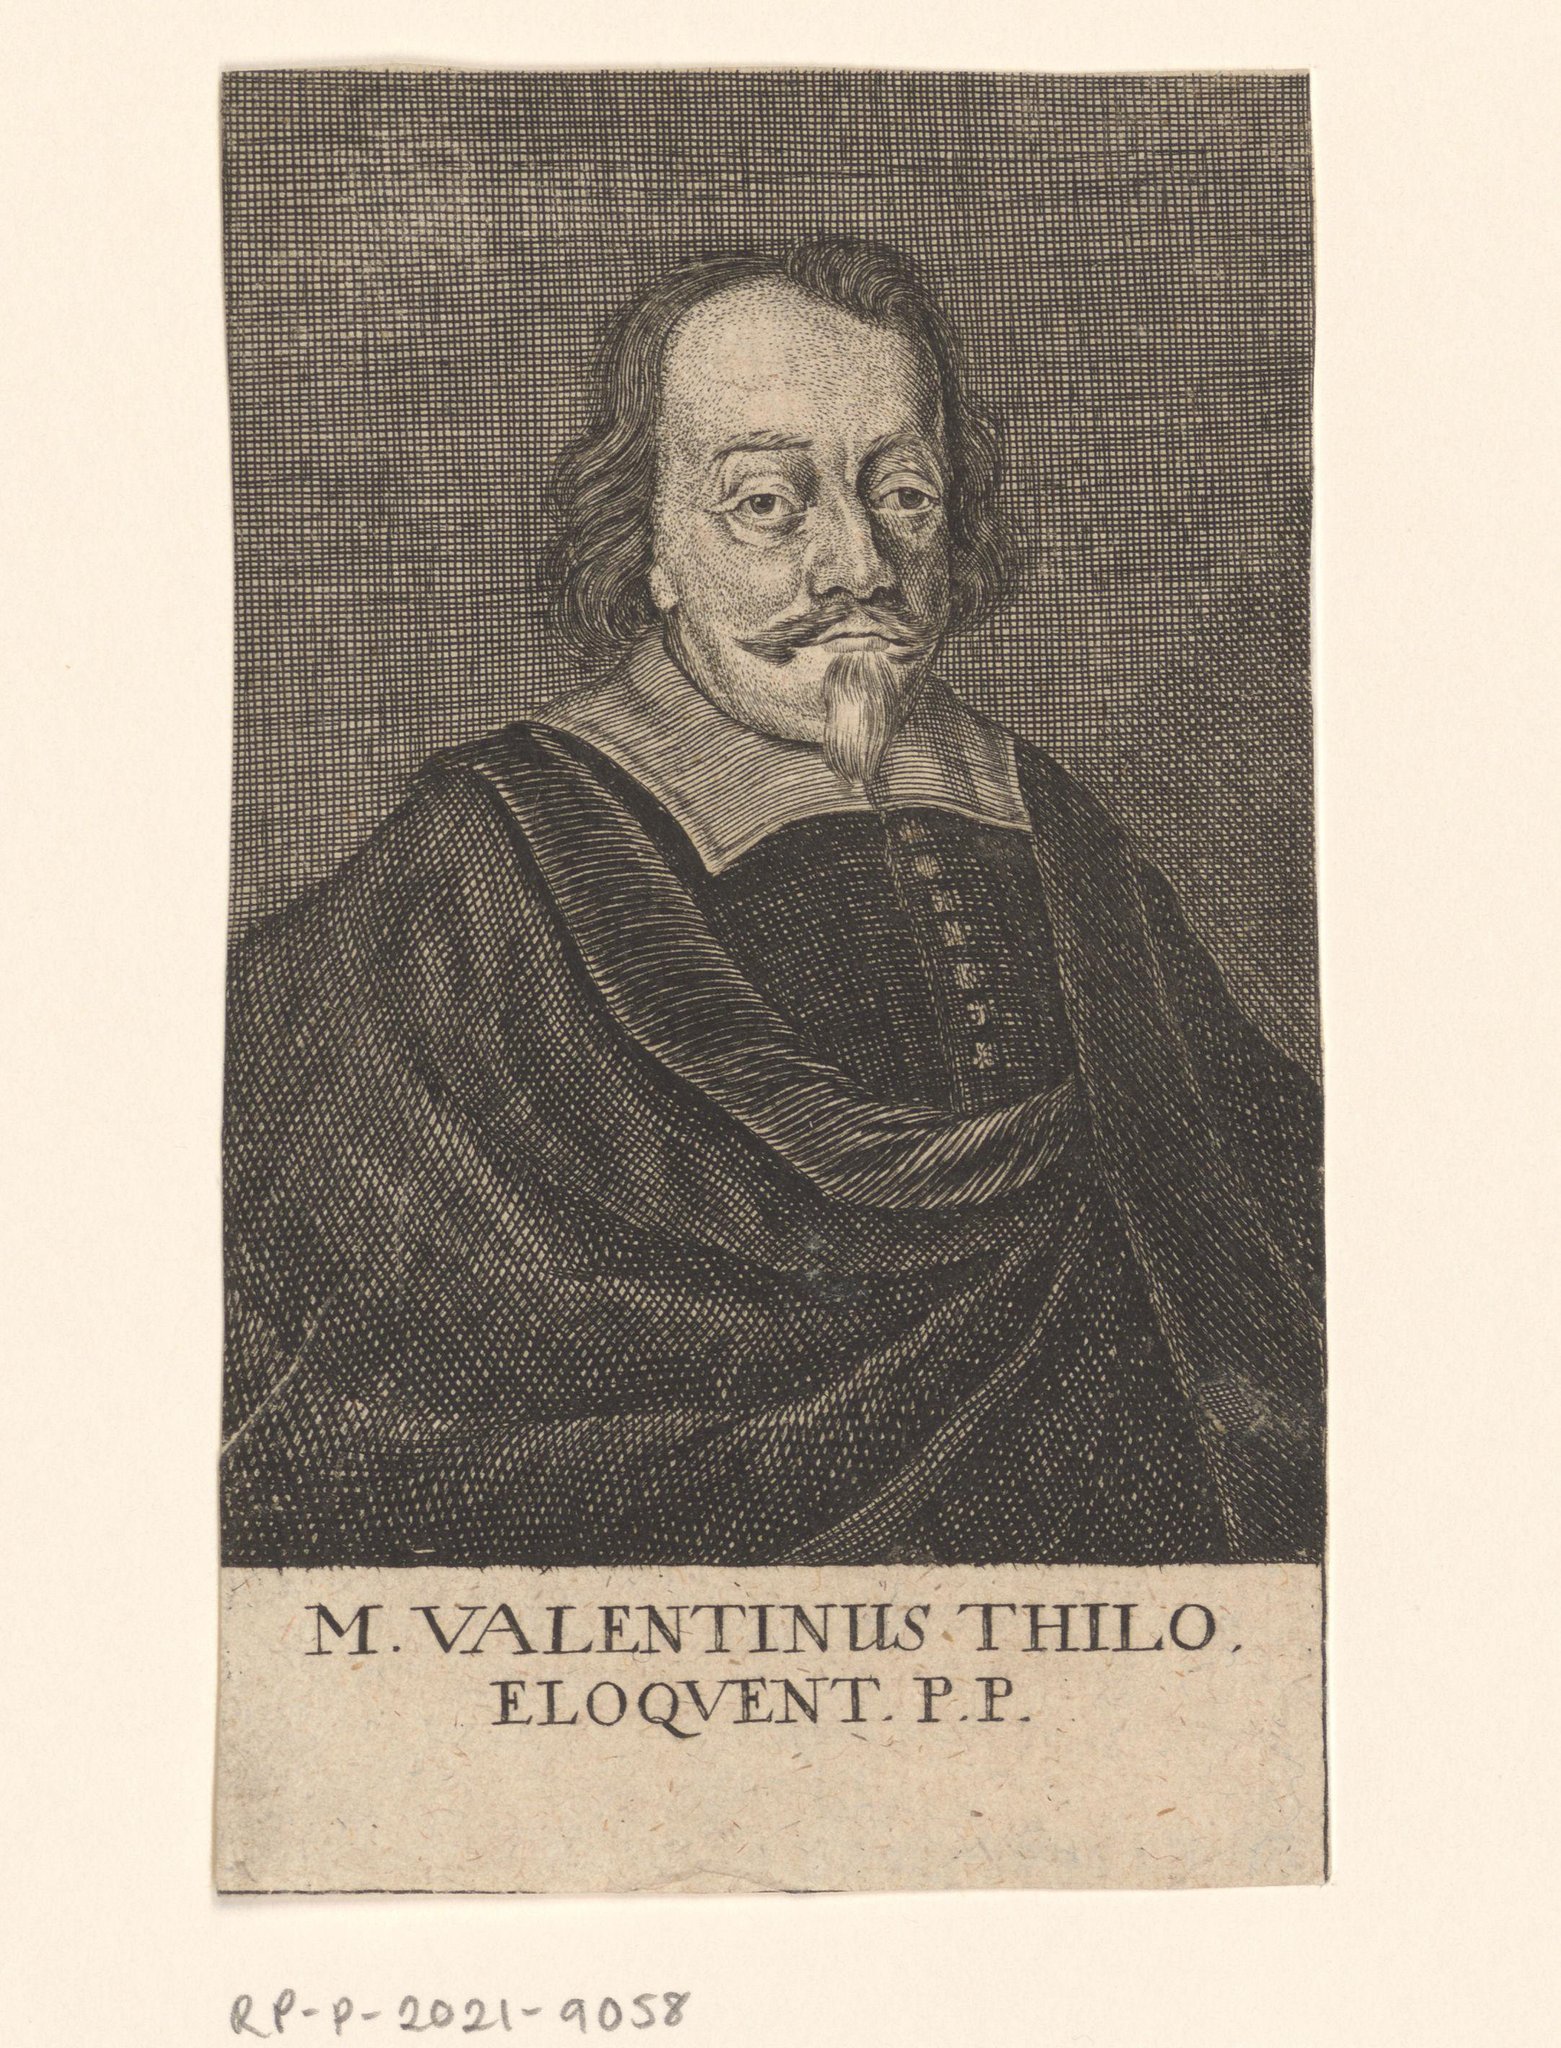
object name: print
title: Portret van Valentin Thilo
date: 1694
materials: paper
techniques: engraving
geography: danzig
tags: theologian, historical persons, writer, poet, author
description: Prent uit: Kongehl, Michael. Immergrünender Cypressen-Hayn (...). Danzig: Martin Hallervord II, 1694.